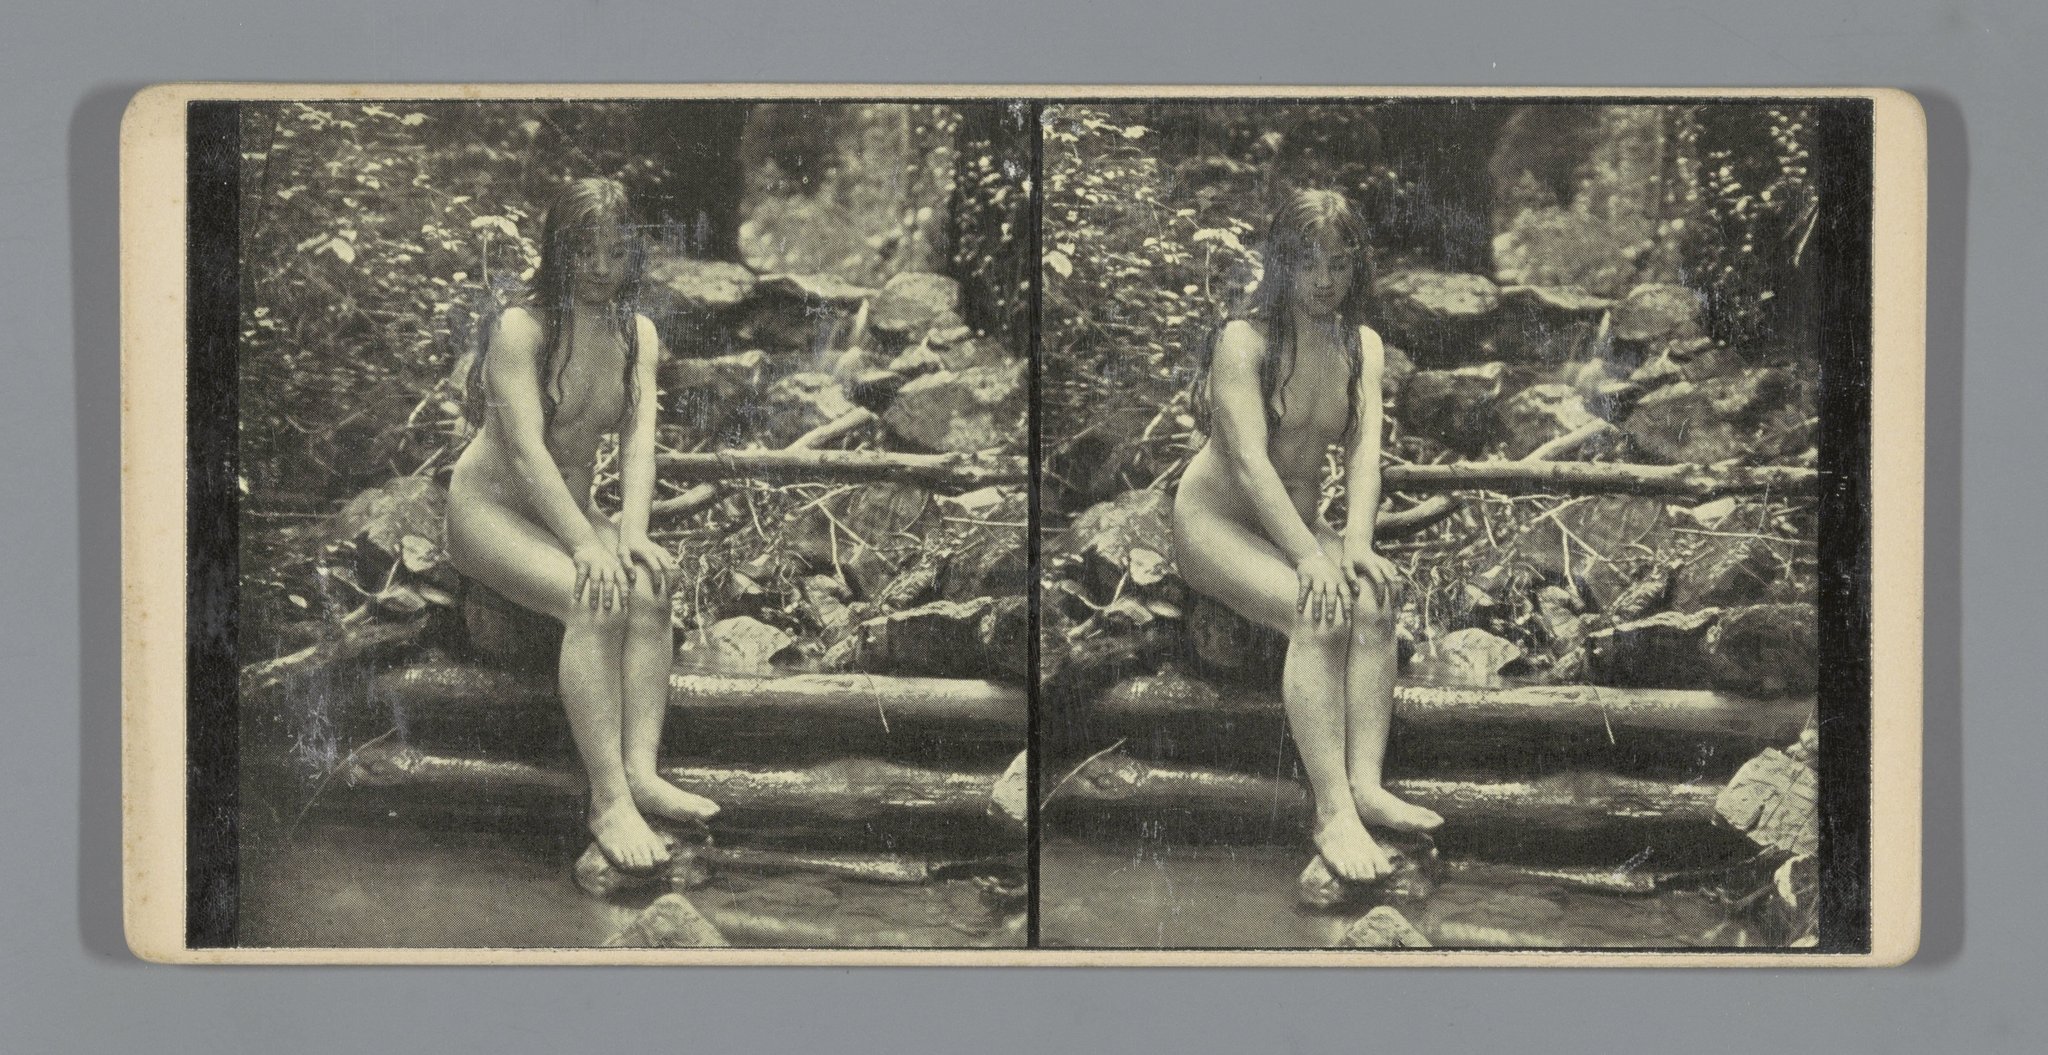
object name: photomechanical print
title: Portret van een naakte vrouw aan de oever van een beek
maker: Anonymous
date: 1873-1910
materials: cardboard, paper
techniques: autotype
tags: woman (showing herself) undressed, quasi-nude, anonymous historical person portrayed